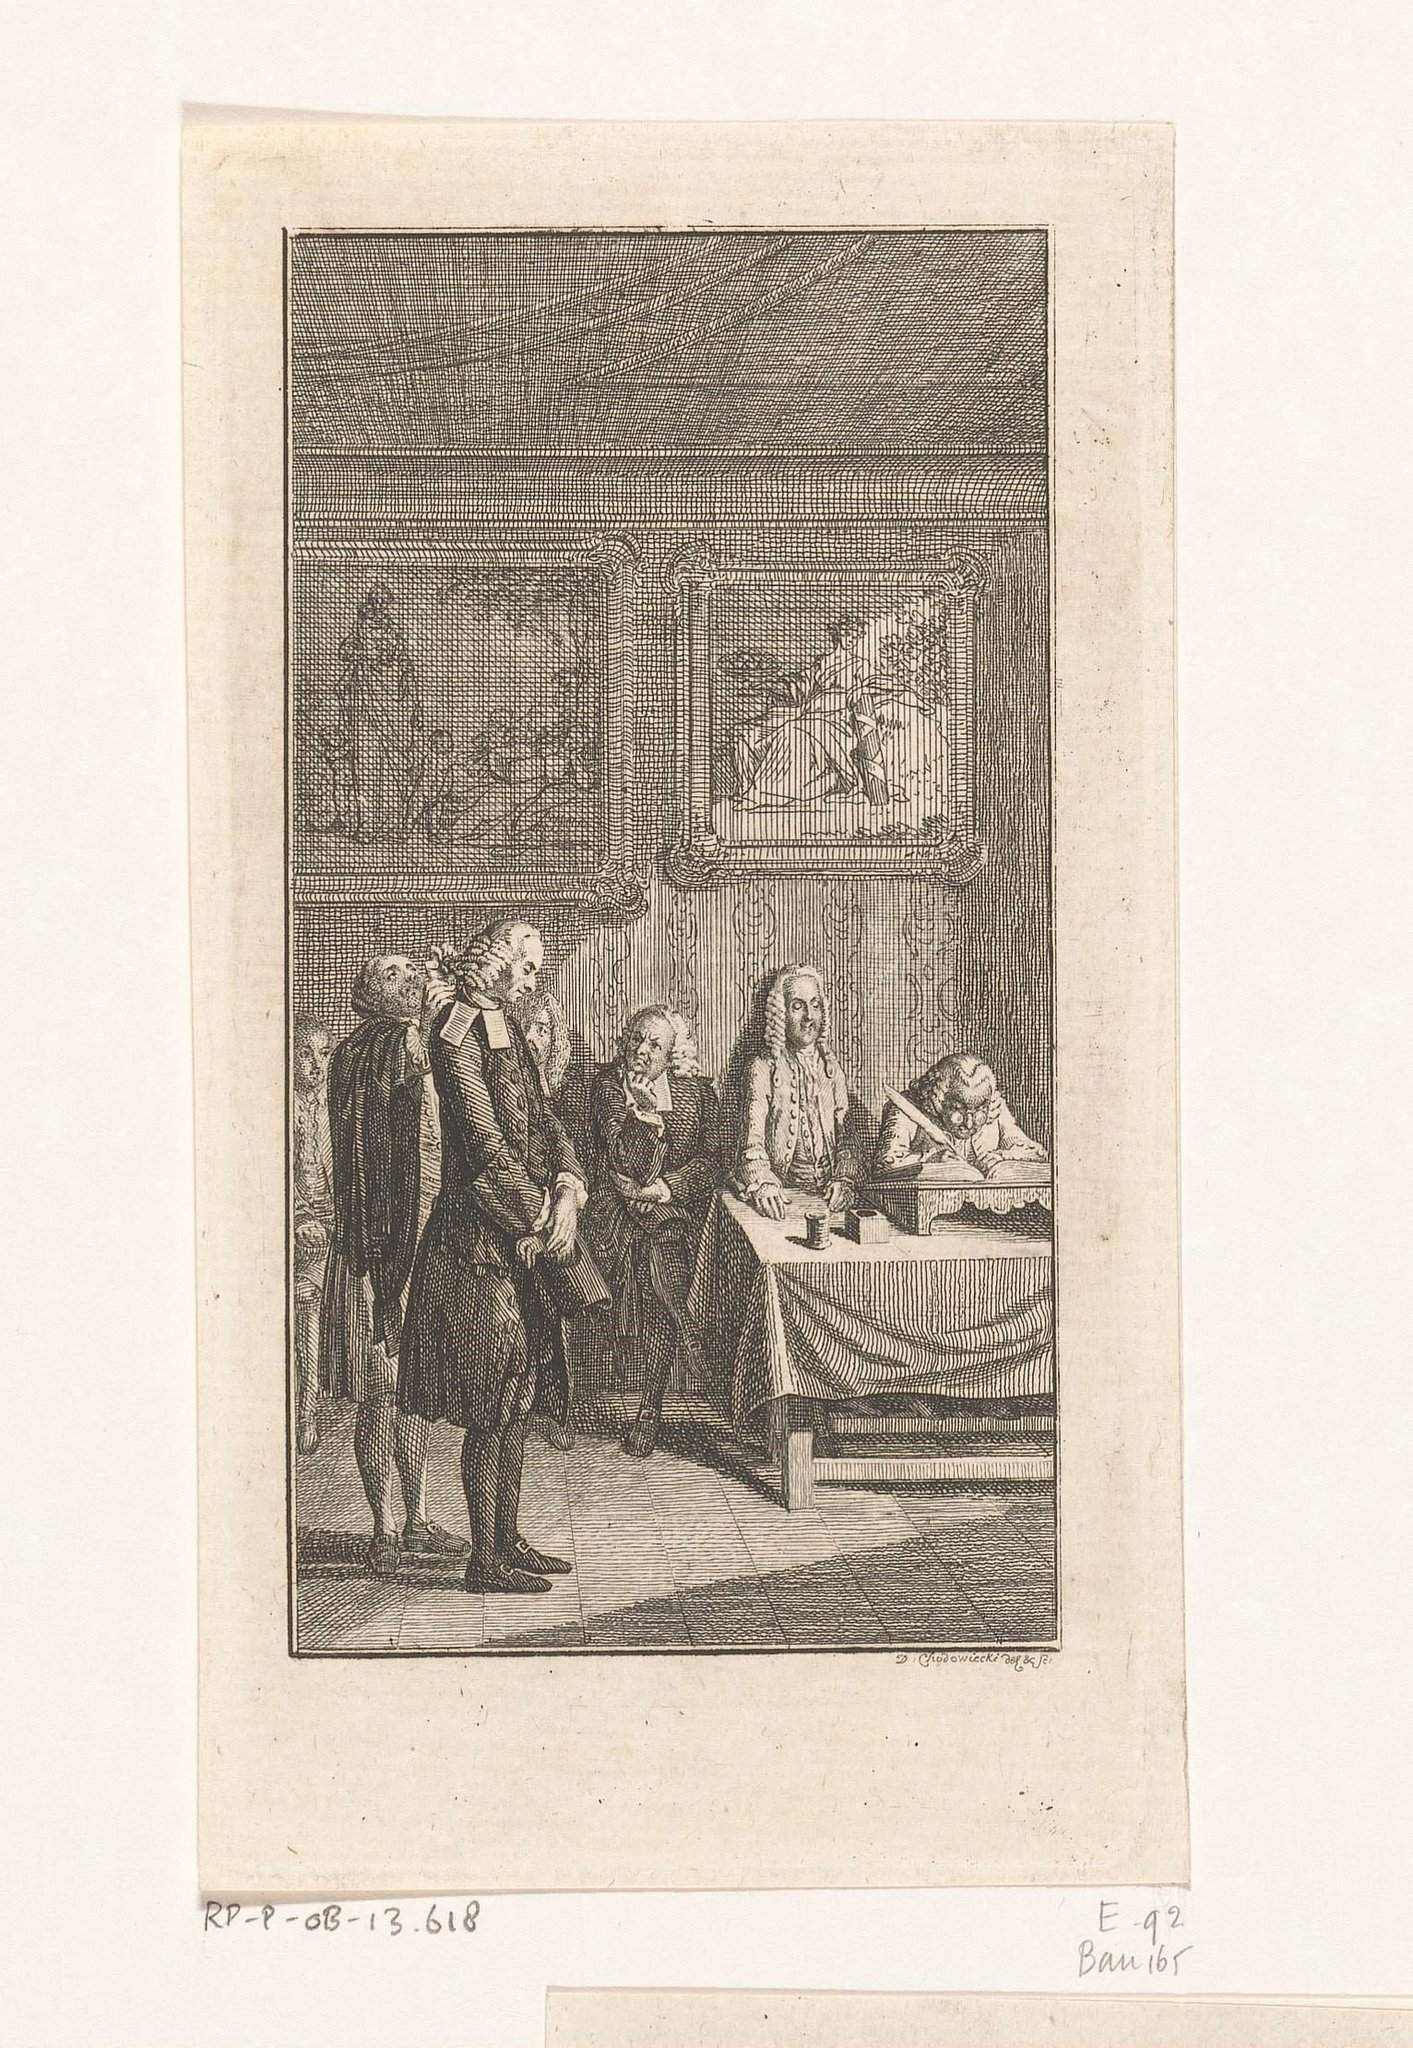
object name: print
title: Sebaldus Nothanker afgezet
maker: daniel nikolaus chodowiecki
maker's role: draughtsman, print maker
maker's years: 1726-1801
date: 1773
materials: paper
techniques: etching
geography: berlin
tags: berlin, publisher, friedrich nicolai, organizational aspects ~ protestant churches, literature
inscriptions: collector's mark: Lugt 240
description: Deze scène behoort tot een serie prenten die het verhaal van Sebaldus Nothanker door Friedrich Nicolai illustreren. De tweede staat van deze serie werd gebruikt in: [Nicolai Friedrich]. Das Leben und die Meinungen des Herrn Magister Sebaldus Nothanker. Berlijn en Stettin: Friedrich Nicolai, 1773 [eerste editie], dl. 1.